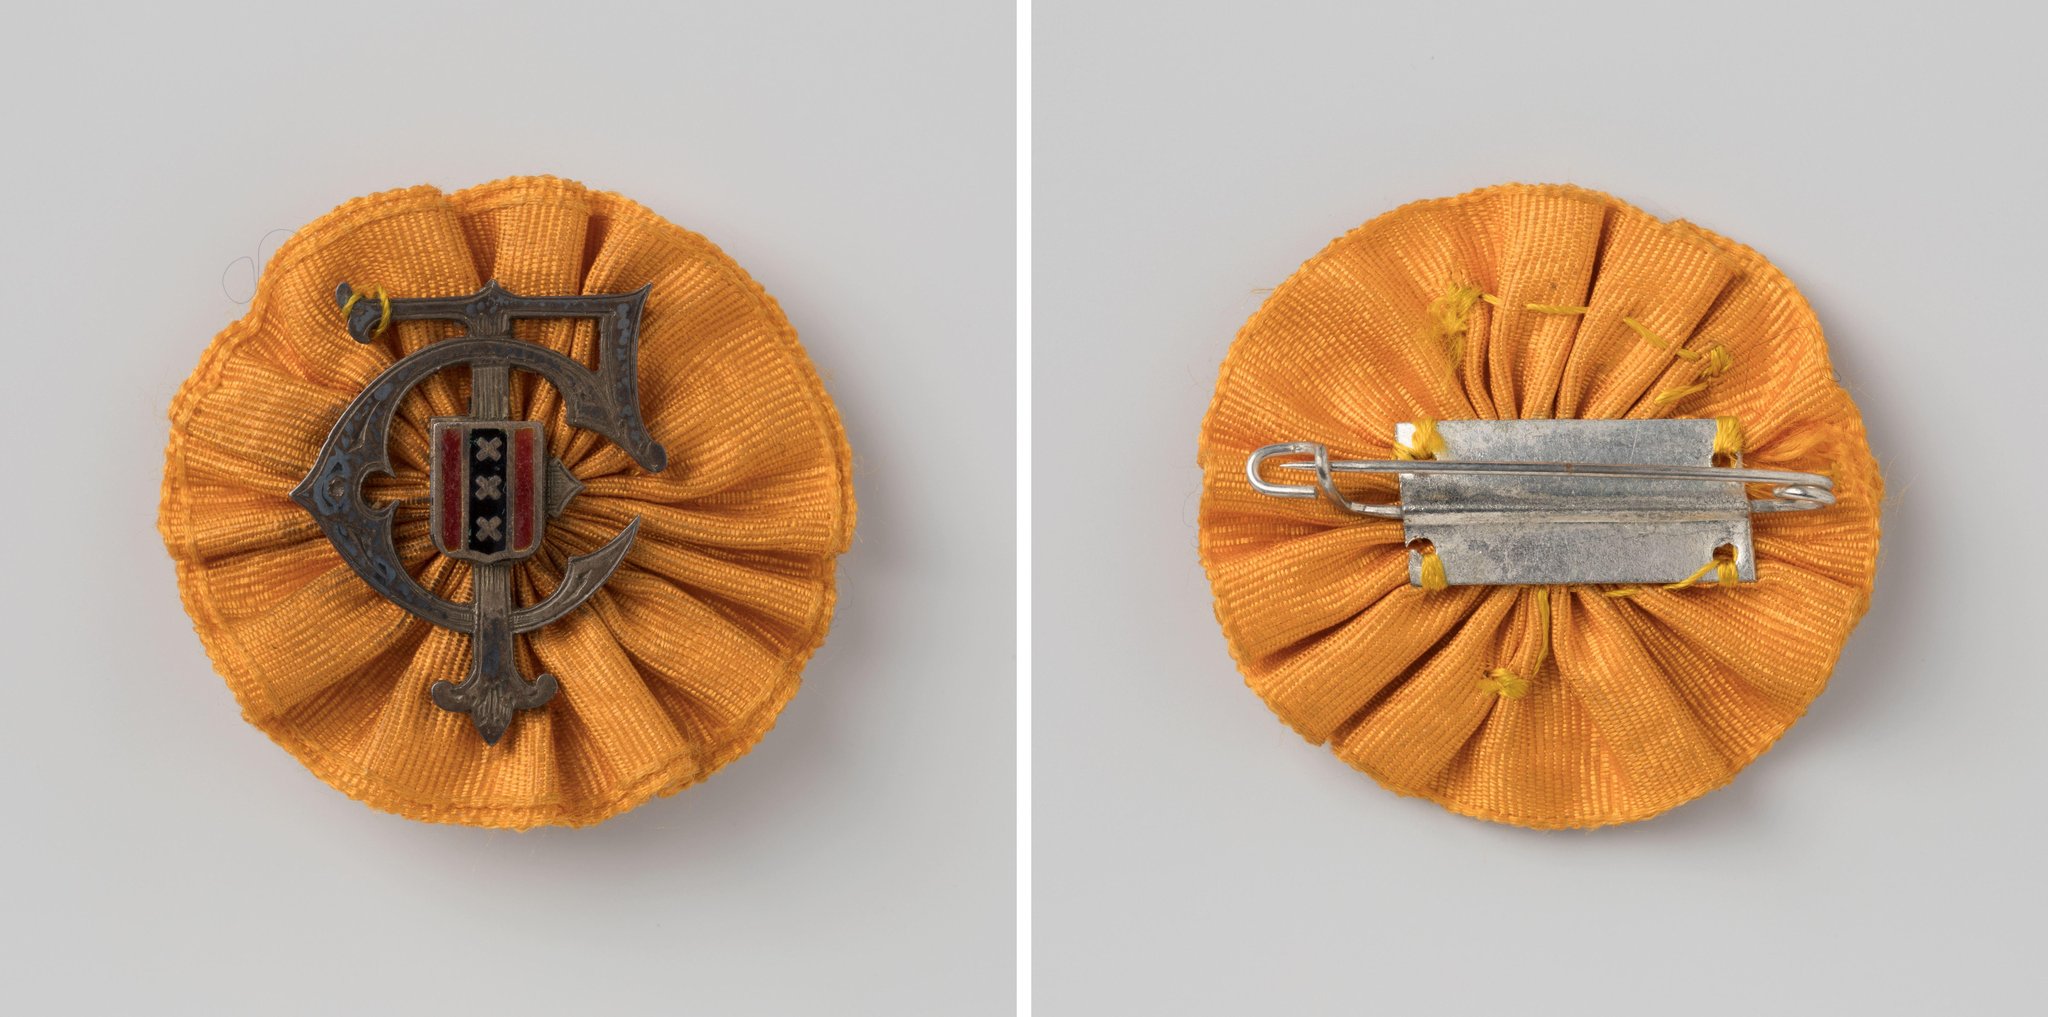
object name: history medal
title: Broche met monogram CF, Amsterdam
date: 1850-1900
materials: iron, silver, textile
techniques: printing, soldering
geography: amsterdam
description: Broche met oranje cocarde waarop een zilveren monogram CF met gesoldeerd een geëmailleerd wapenschildje Amsterdam